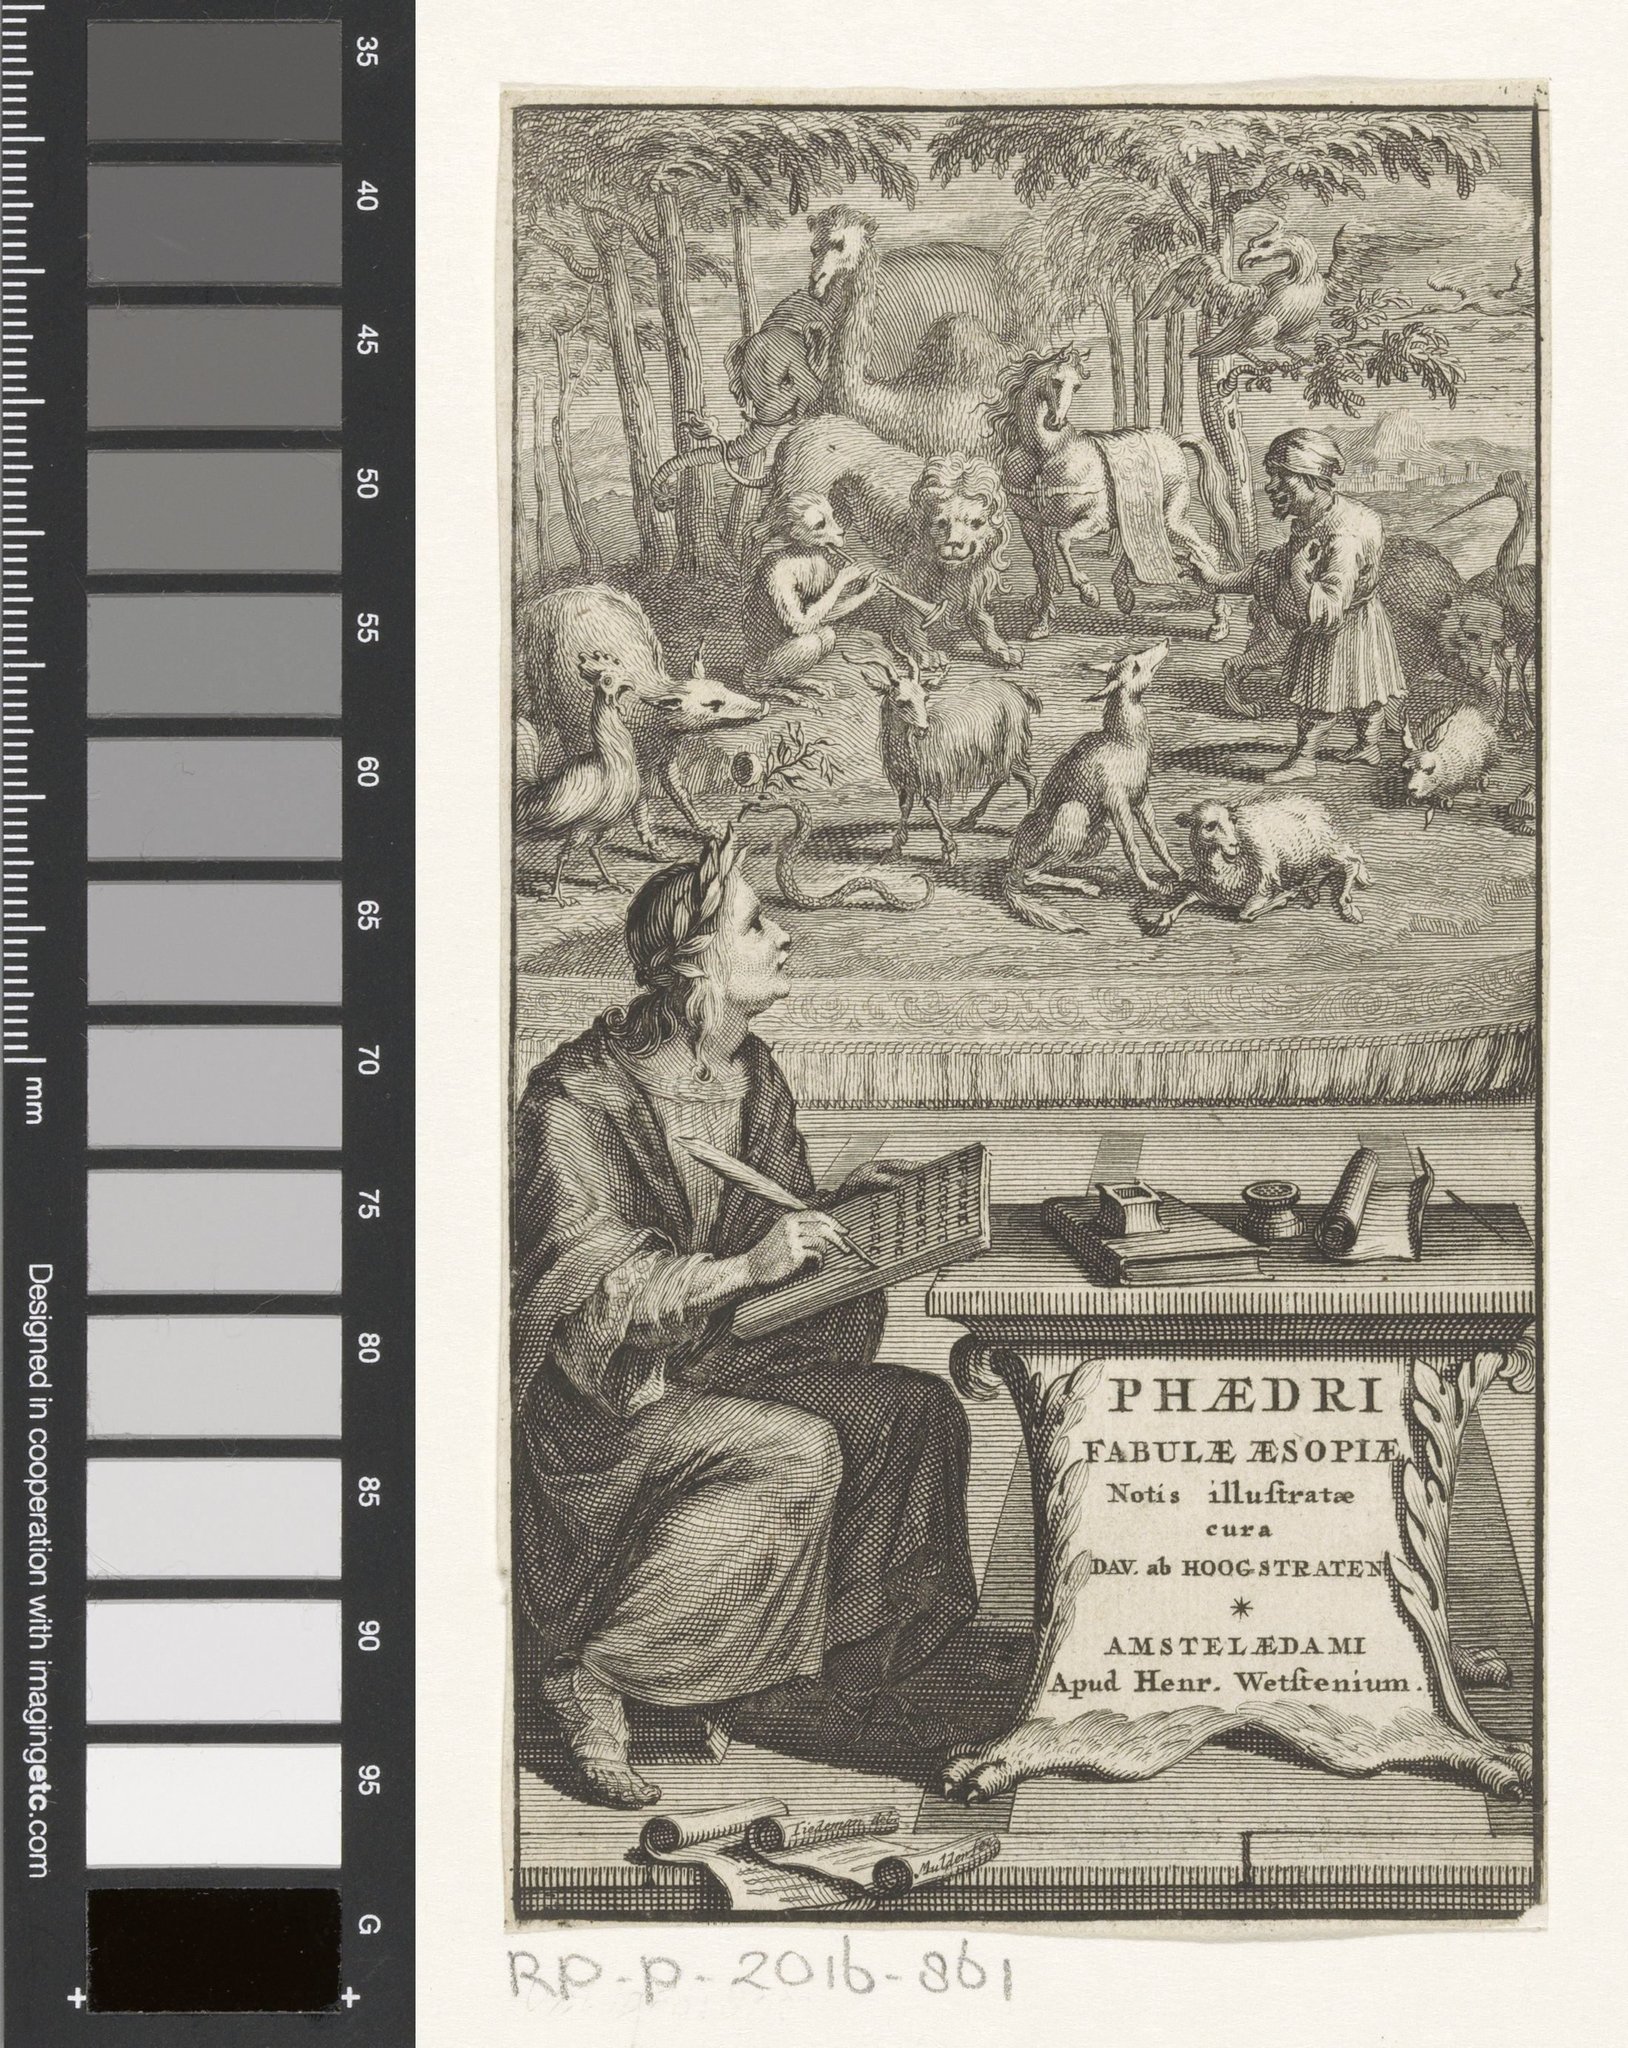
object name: print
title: Schrijver en dieren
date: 1699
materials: paper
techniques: etching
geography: amsterdam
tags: aesopus, fables of aesop : use 85(...), writer, poet, author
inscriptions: collector's mark: Lugt 2228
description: Titelpagina voor: Hoogstraten, David van. Phaedri fabulae aesopiae. Amsterdam: Linden, Dirk en Gerard Adriaan onder de, 1699. Prent afkomstig uit een plakalbum met titelprenten, ornamenten etc. op blauw papier in 1983 uit elkaar gehaald. Volgens een notitie op verso zat de prent op p. 214 van dit album.